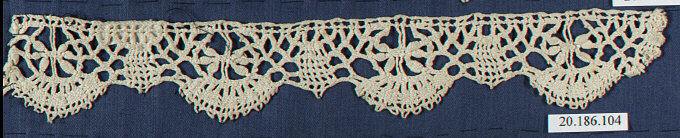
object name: edging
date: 1601-1700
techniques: lace